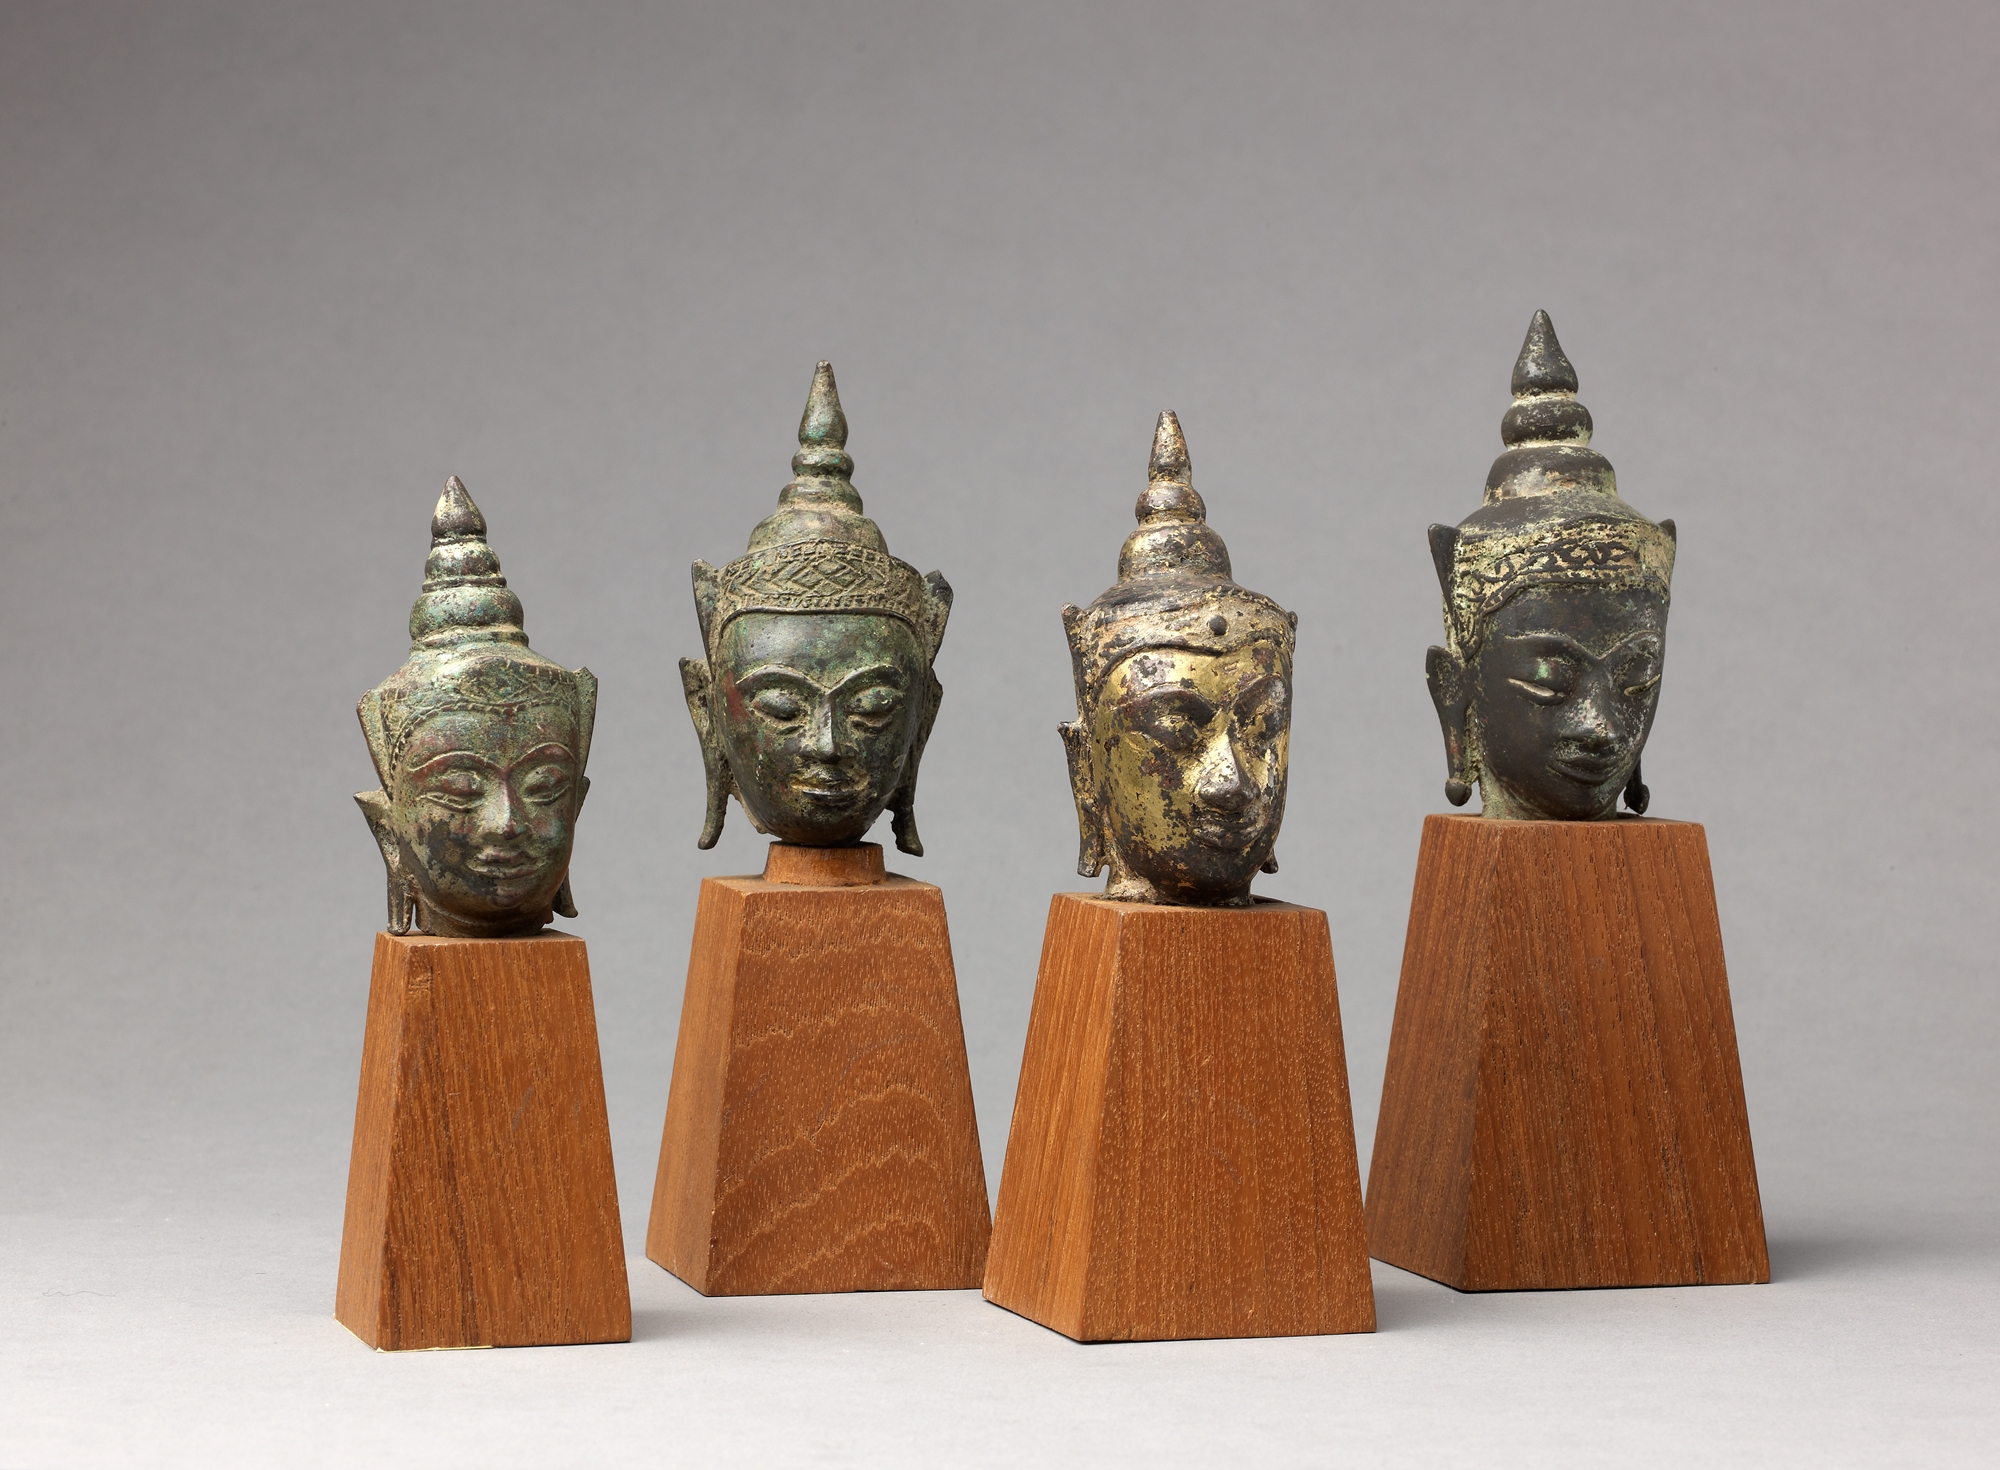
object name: sculpture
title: Head of the Buddha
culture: thai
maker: thai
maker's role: artist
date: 1767-1900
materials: copper alloy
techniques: gilding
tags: heads,buddha